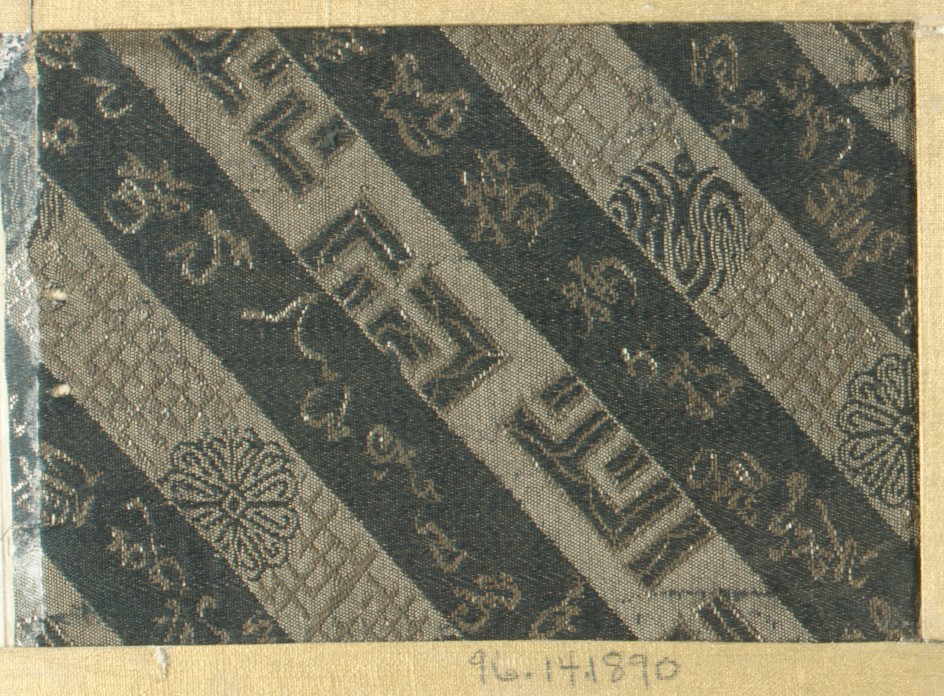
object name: piece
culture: japanese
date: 1701-1900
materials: silk